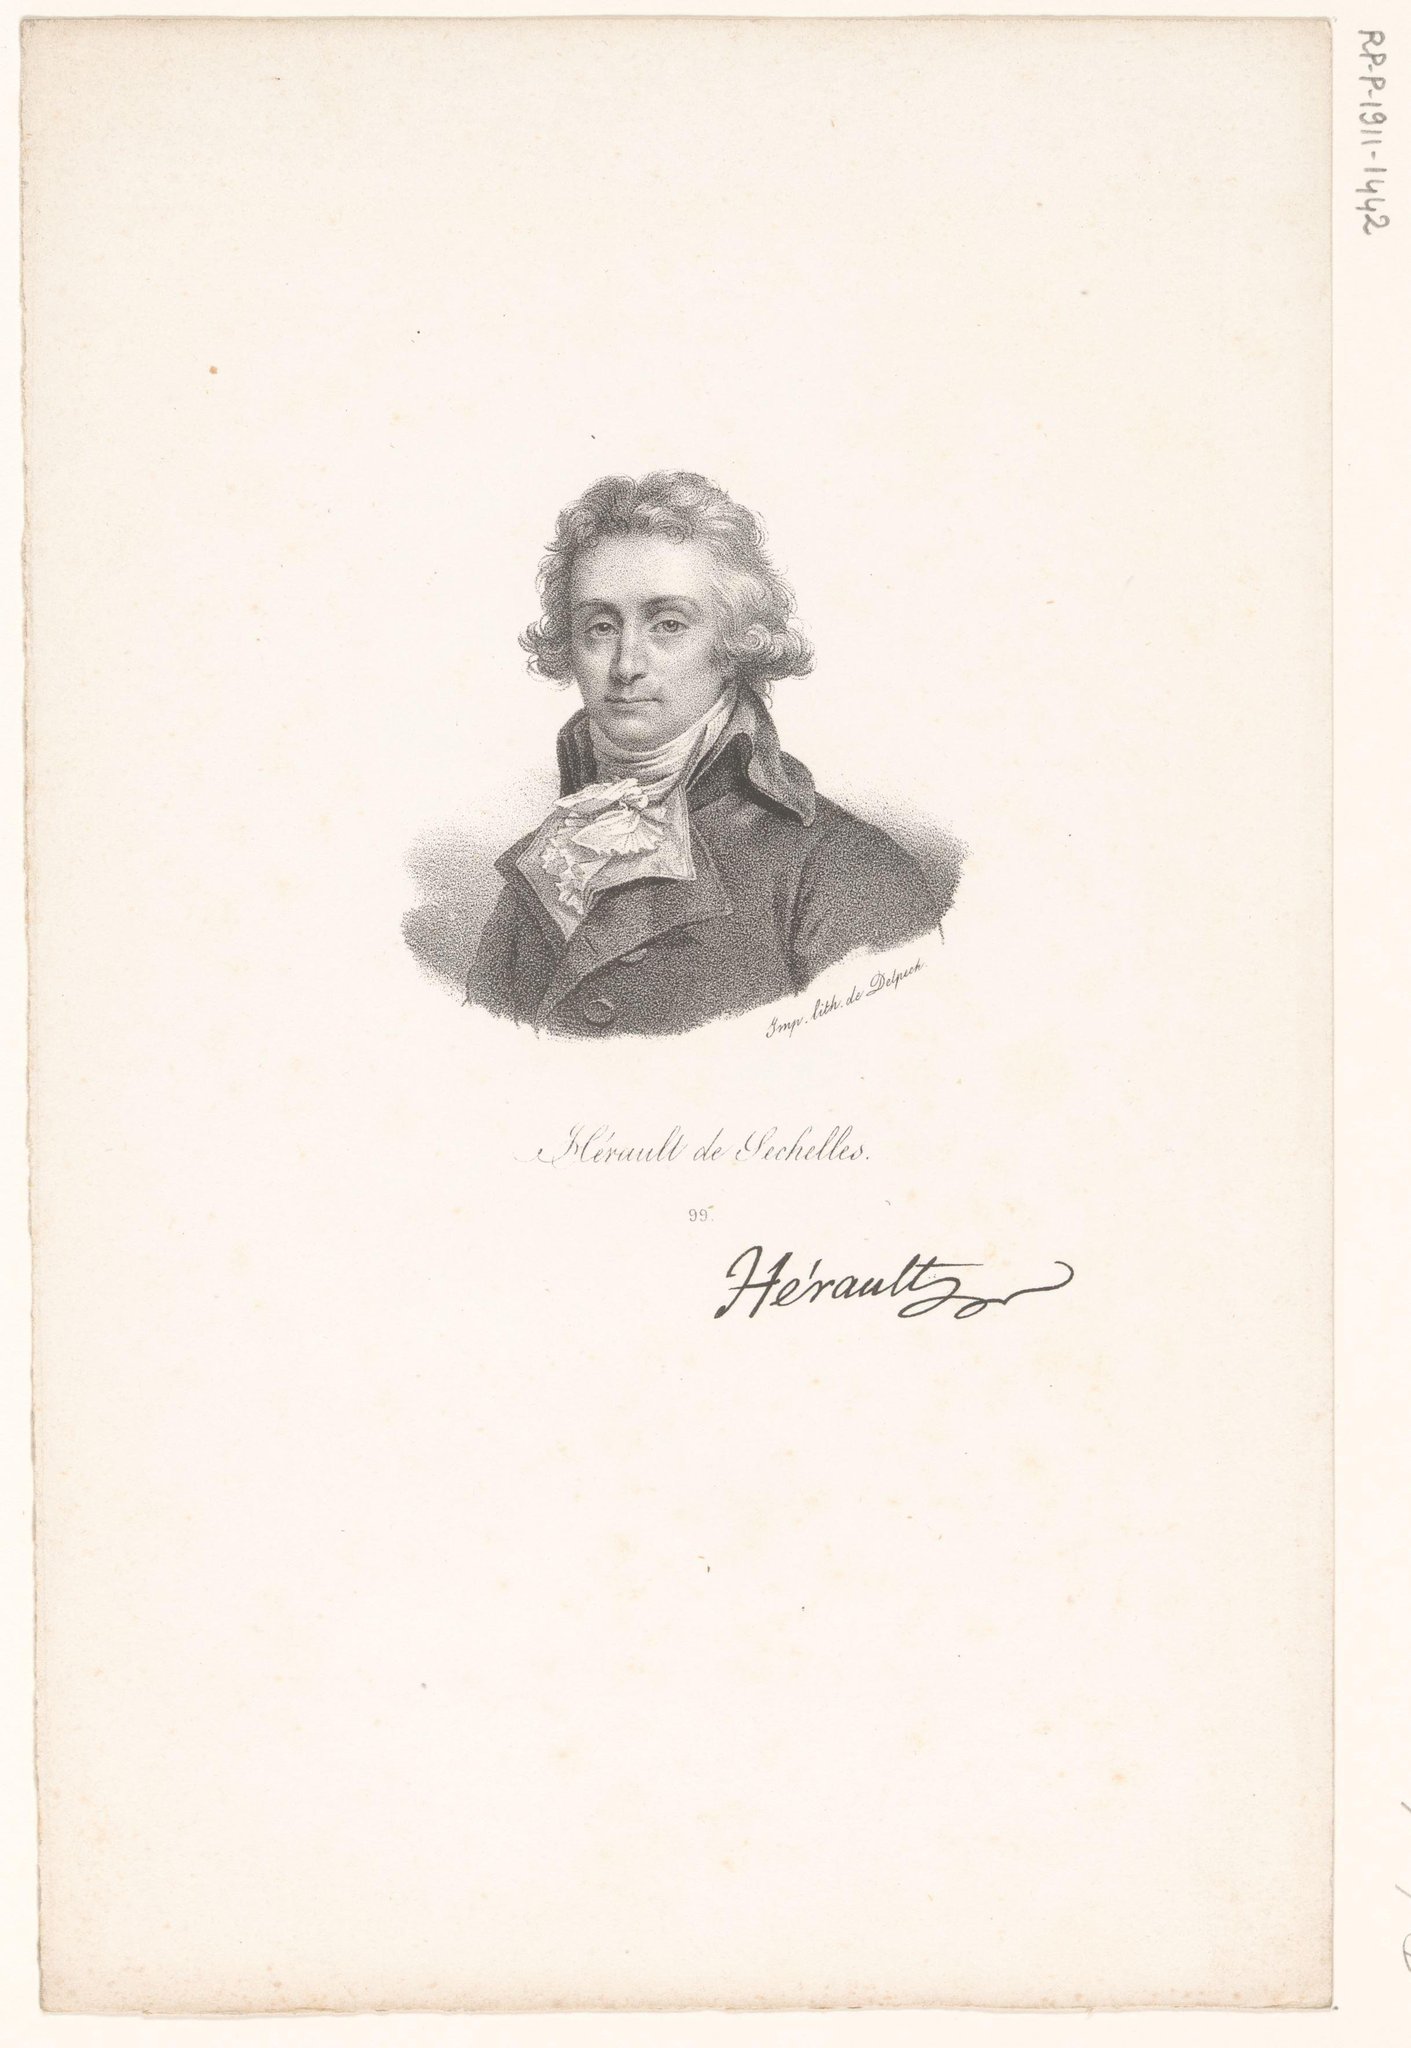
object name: print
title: Hérault de Sechelles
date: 1818-1842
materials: paper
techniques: lithograph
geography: paris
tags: paris, politician, historical persons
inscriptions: collector's mark: Lugt 2228a